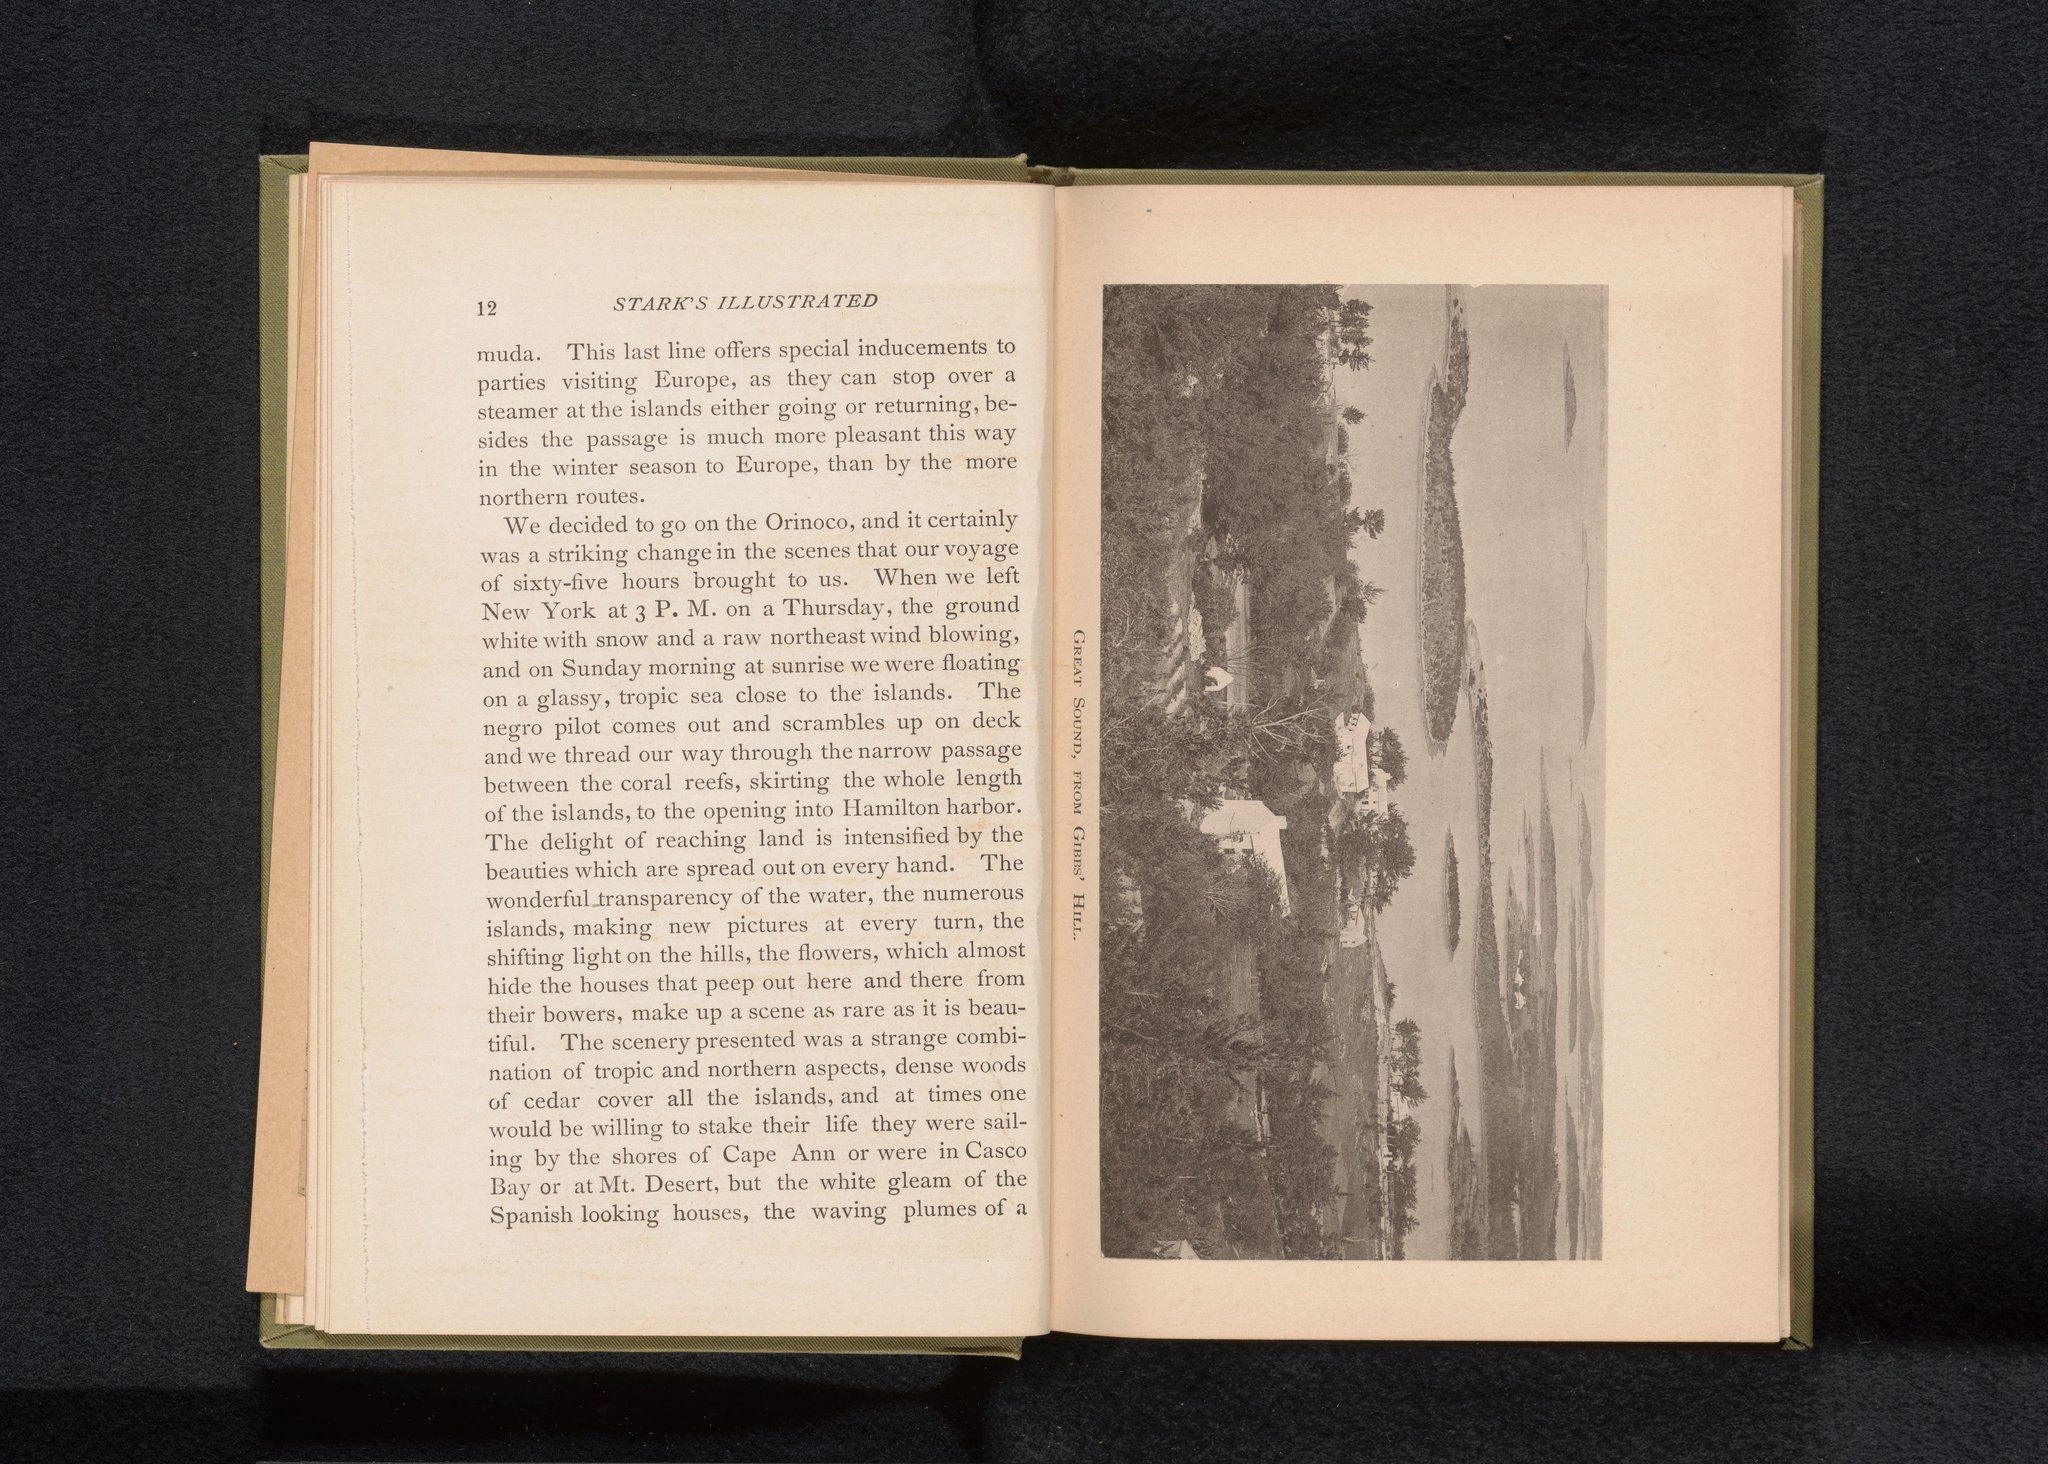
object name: page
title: Great Sound, from Gibbs' Hills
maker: james h. stark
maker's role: fotograaf, schrijver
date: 1879-1884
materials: paper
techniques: photograph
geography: boston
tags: coastal inlet